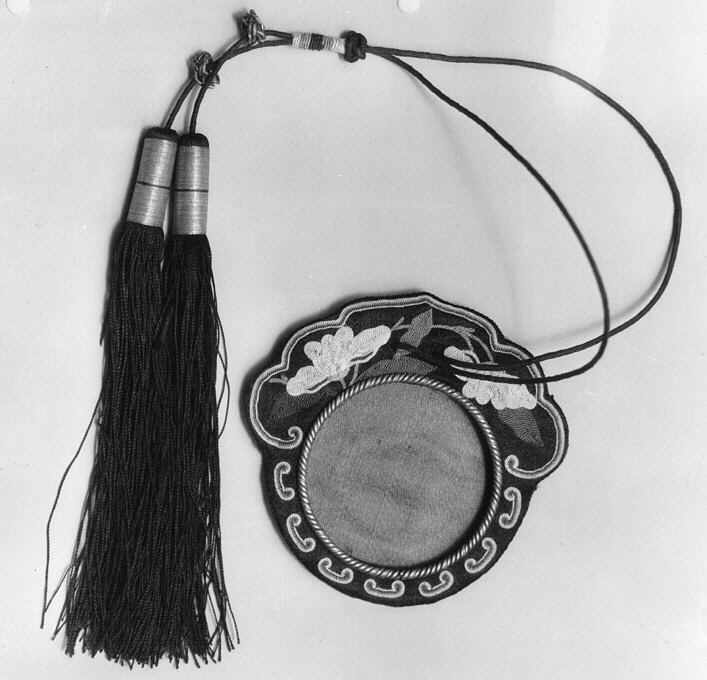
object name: mirror case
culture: chinese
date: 1701-1900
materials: silk